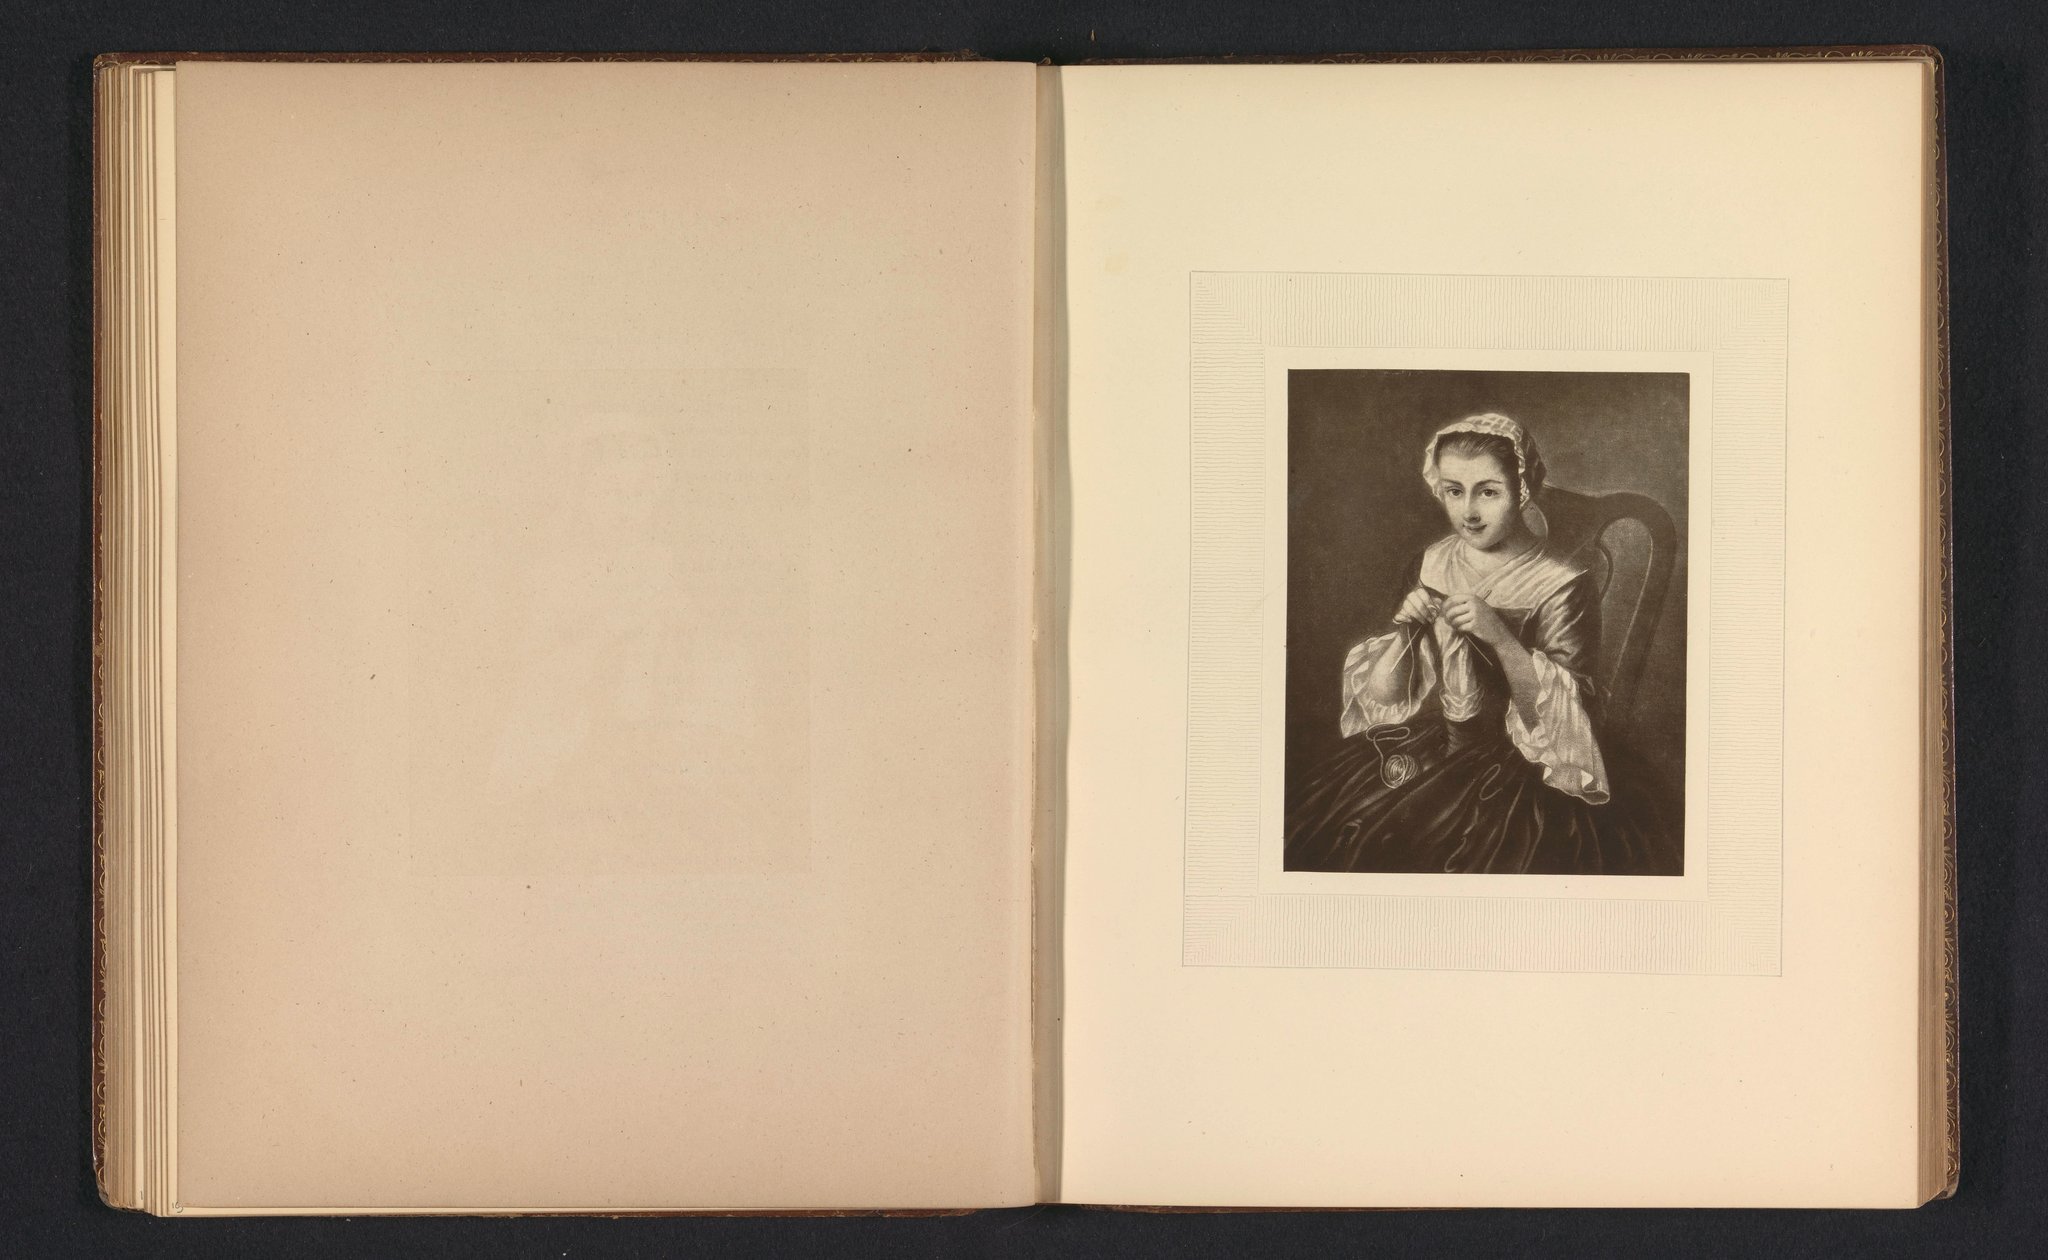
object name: page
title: Fotoreproductie van een prent naar een schilderij met een breiende vrouw door Philippe Mercier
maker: Anonymous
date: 1864-1874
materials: paper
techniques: woodburytype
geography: london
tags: knitting, picture, painting